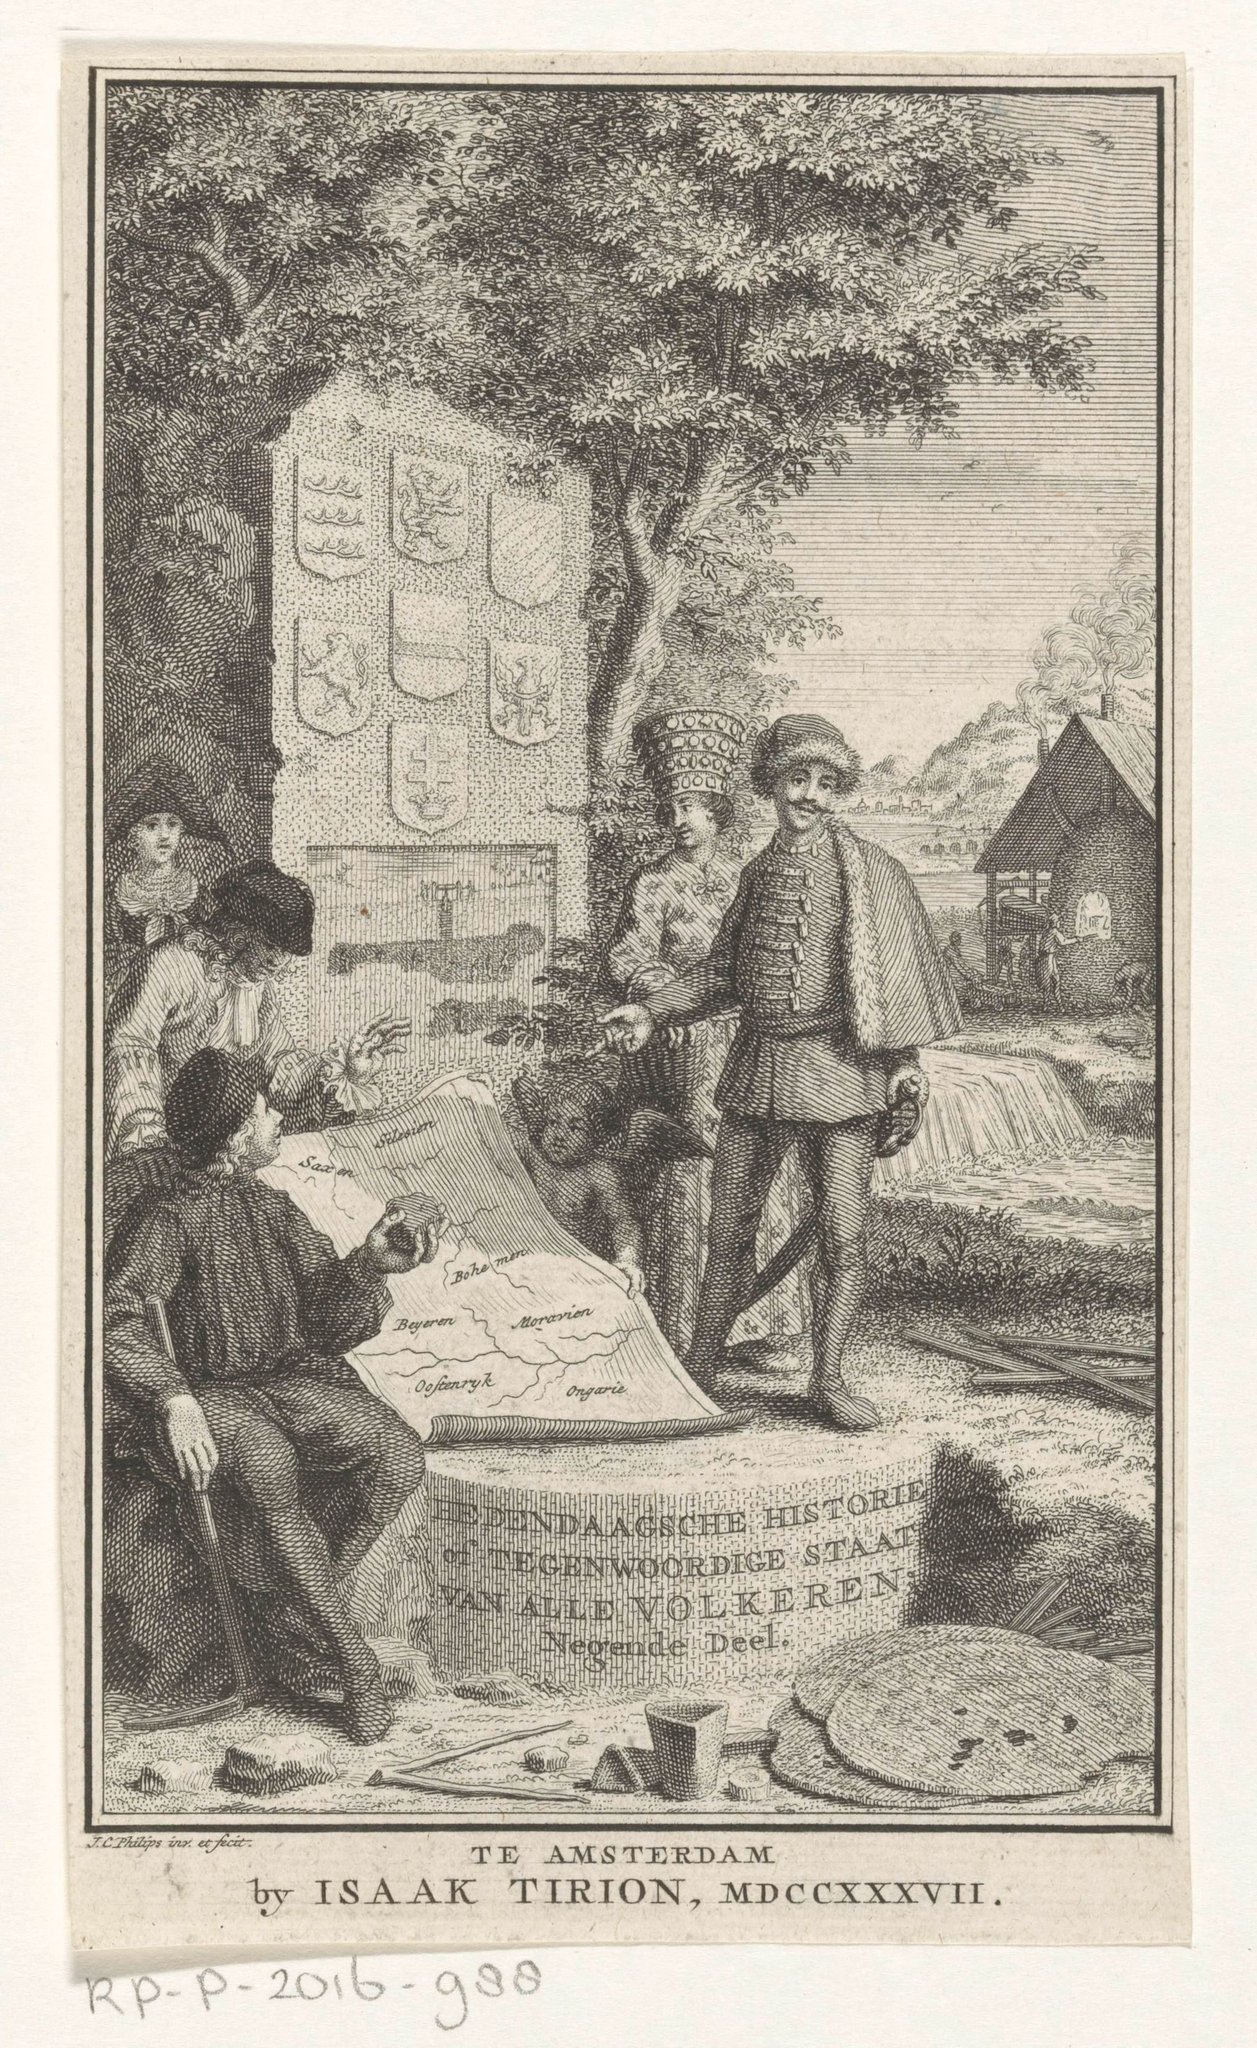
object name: print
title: Groep mannen rondom kaart van het Duitse Rijk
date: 1737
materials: paper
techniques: engraving, etching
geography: amsterdam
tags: standing figure, maps, atlases, oven ~ kitchen - cc - in the open air, germany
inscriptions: collector's mark: Lugt 2228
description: Titelpagina voor: Salmon, Thomas. Hedendaagsche historie of tegenwoordige staat van alle volkeren, IX Deel. Amsterdam: Tirion, Isaak, 1737. Prent afkomstig uit een plakalbum met titelprenten, ornamenten etc. op blauw papier in 1983 uit elkaar gehaald. Volgens een notitie op verso zat de prent op p. 189 van dit album.